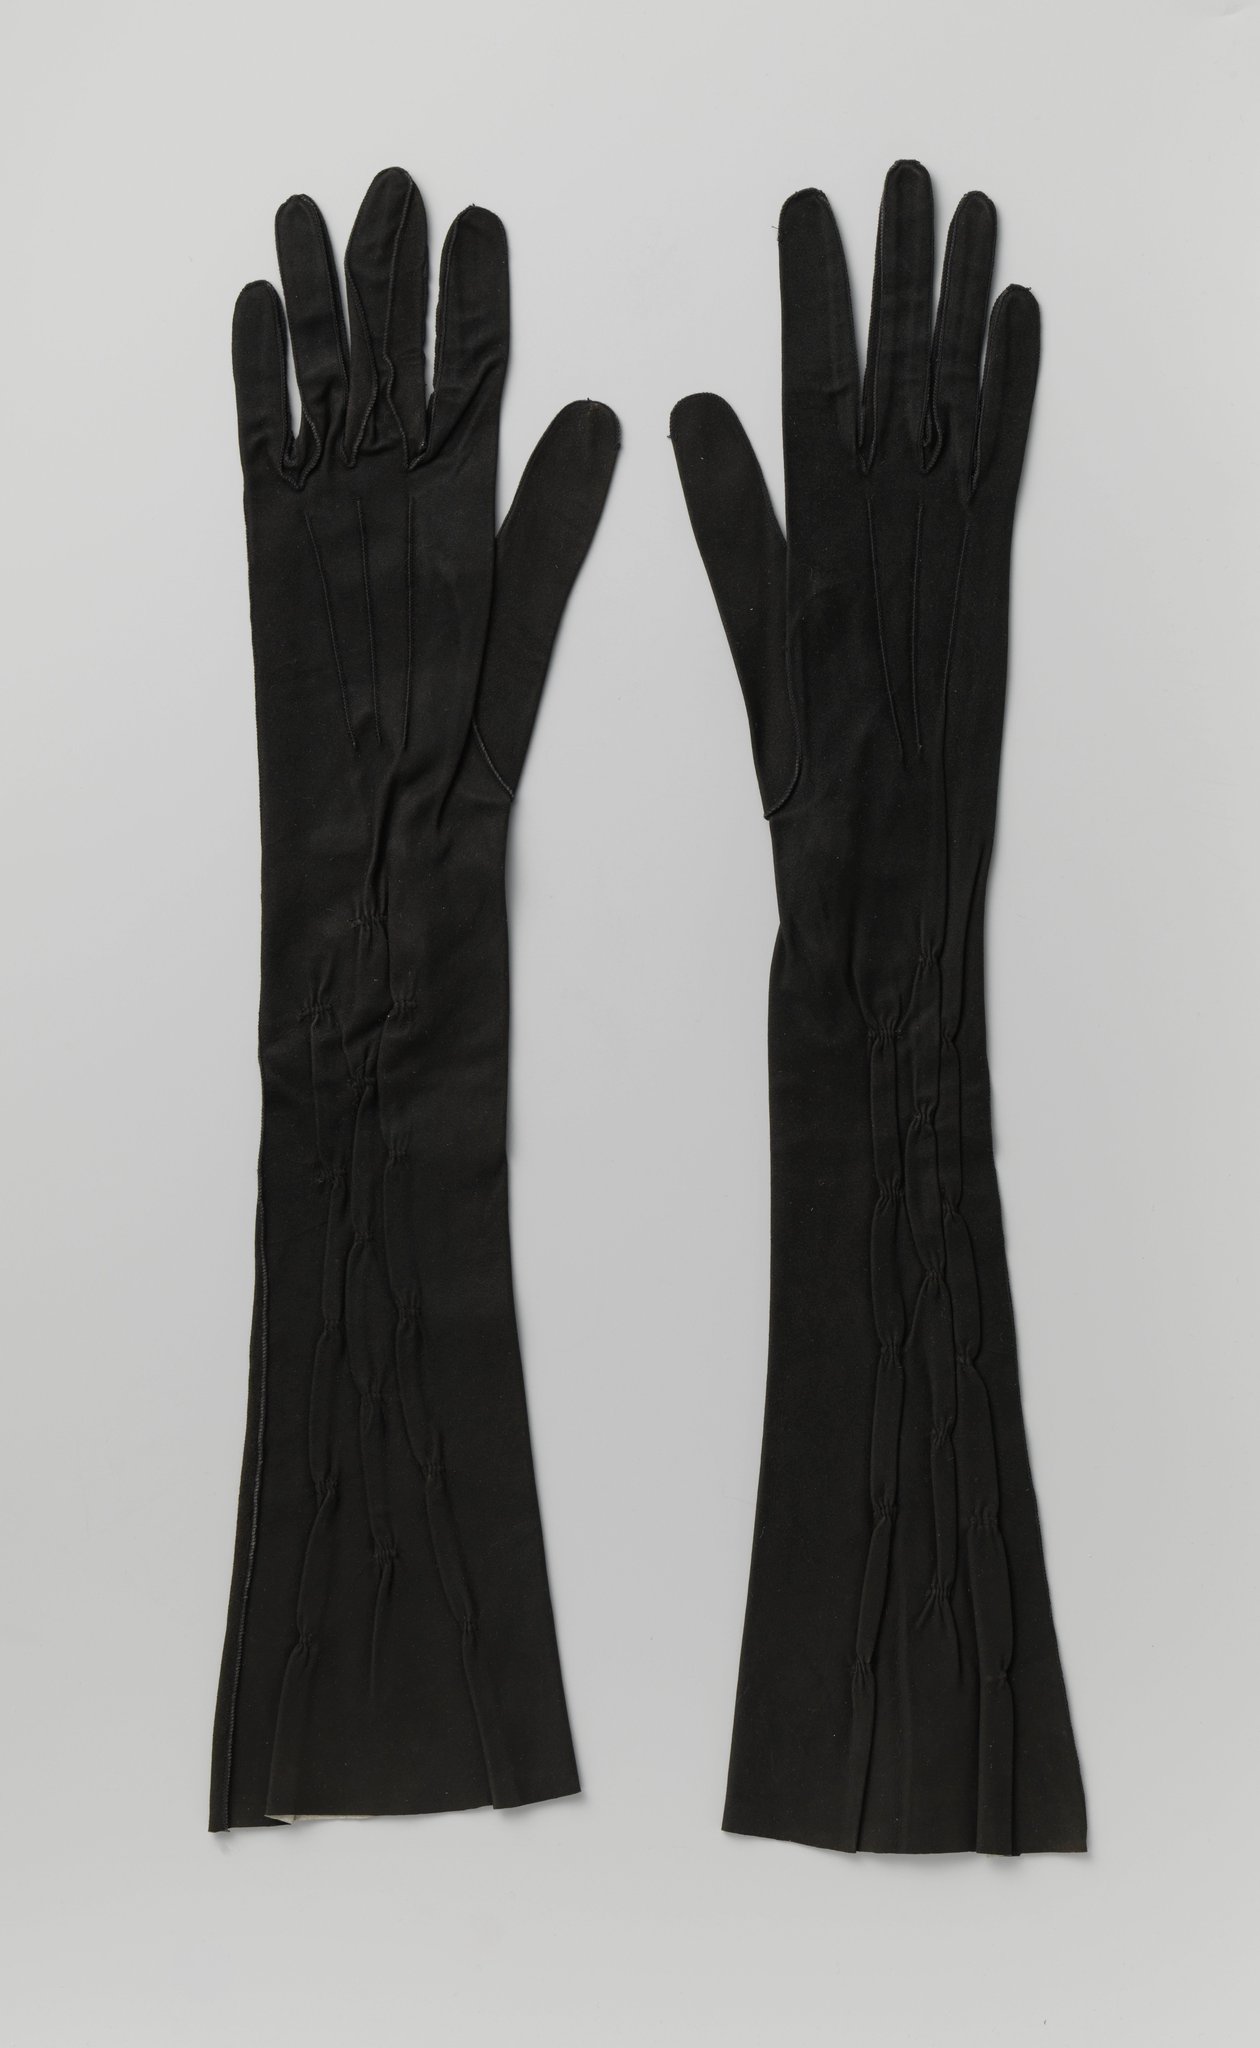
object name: evening glove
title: Pair of gala gloves with drawn up stitching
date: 1950-1960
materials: leather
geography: paris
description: Alexandrine was a Parisian manufacturer specialised in luxury gloves, although they also sold matching bags and stockings. Their gloves were on sale in the Netherlands at Hirsch & Cie.